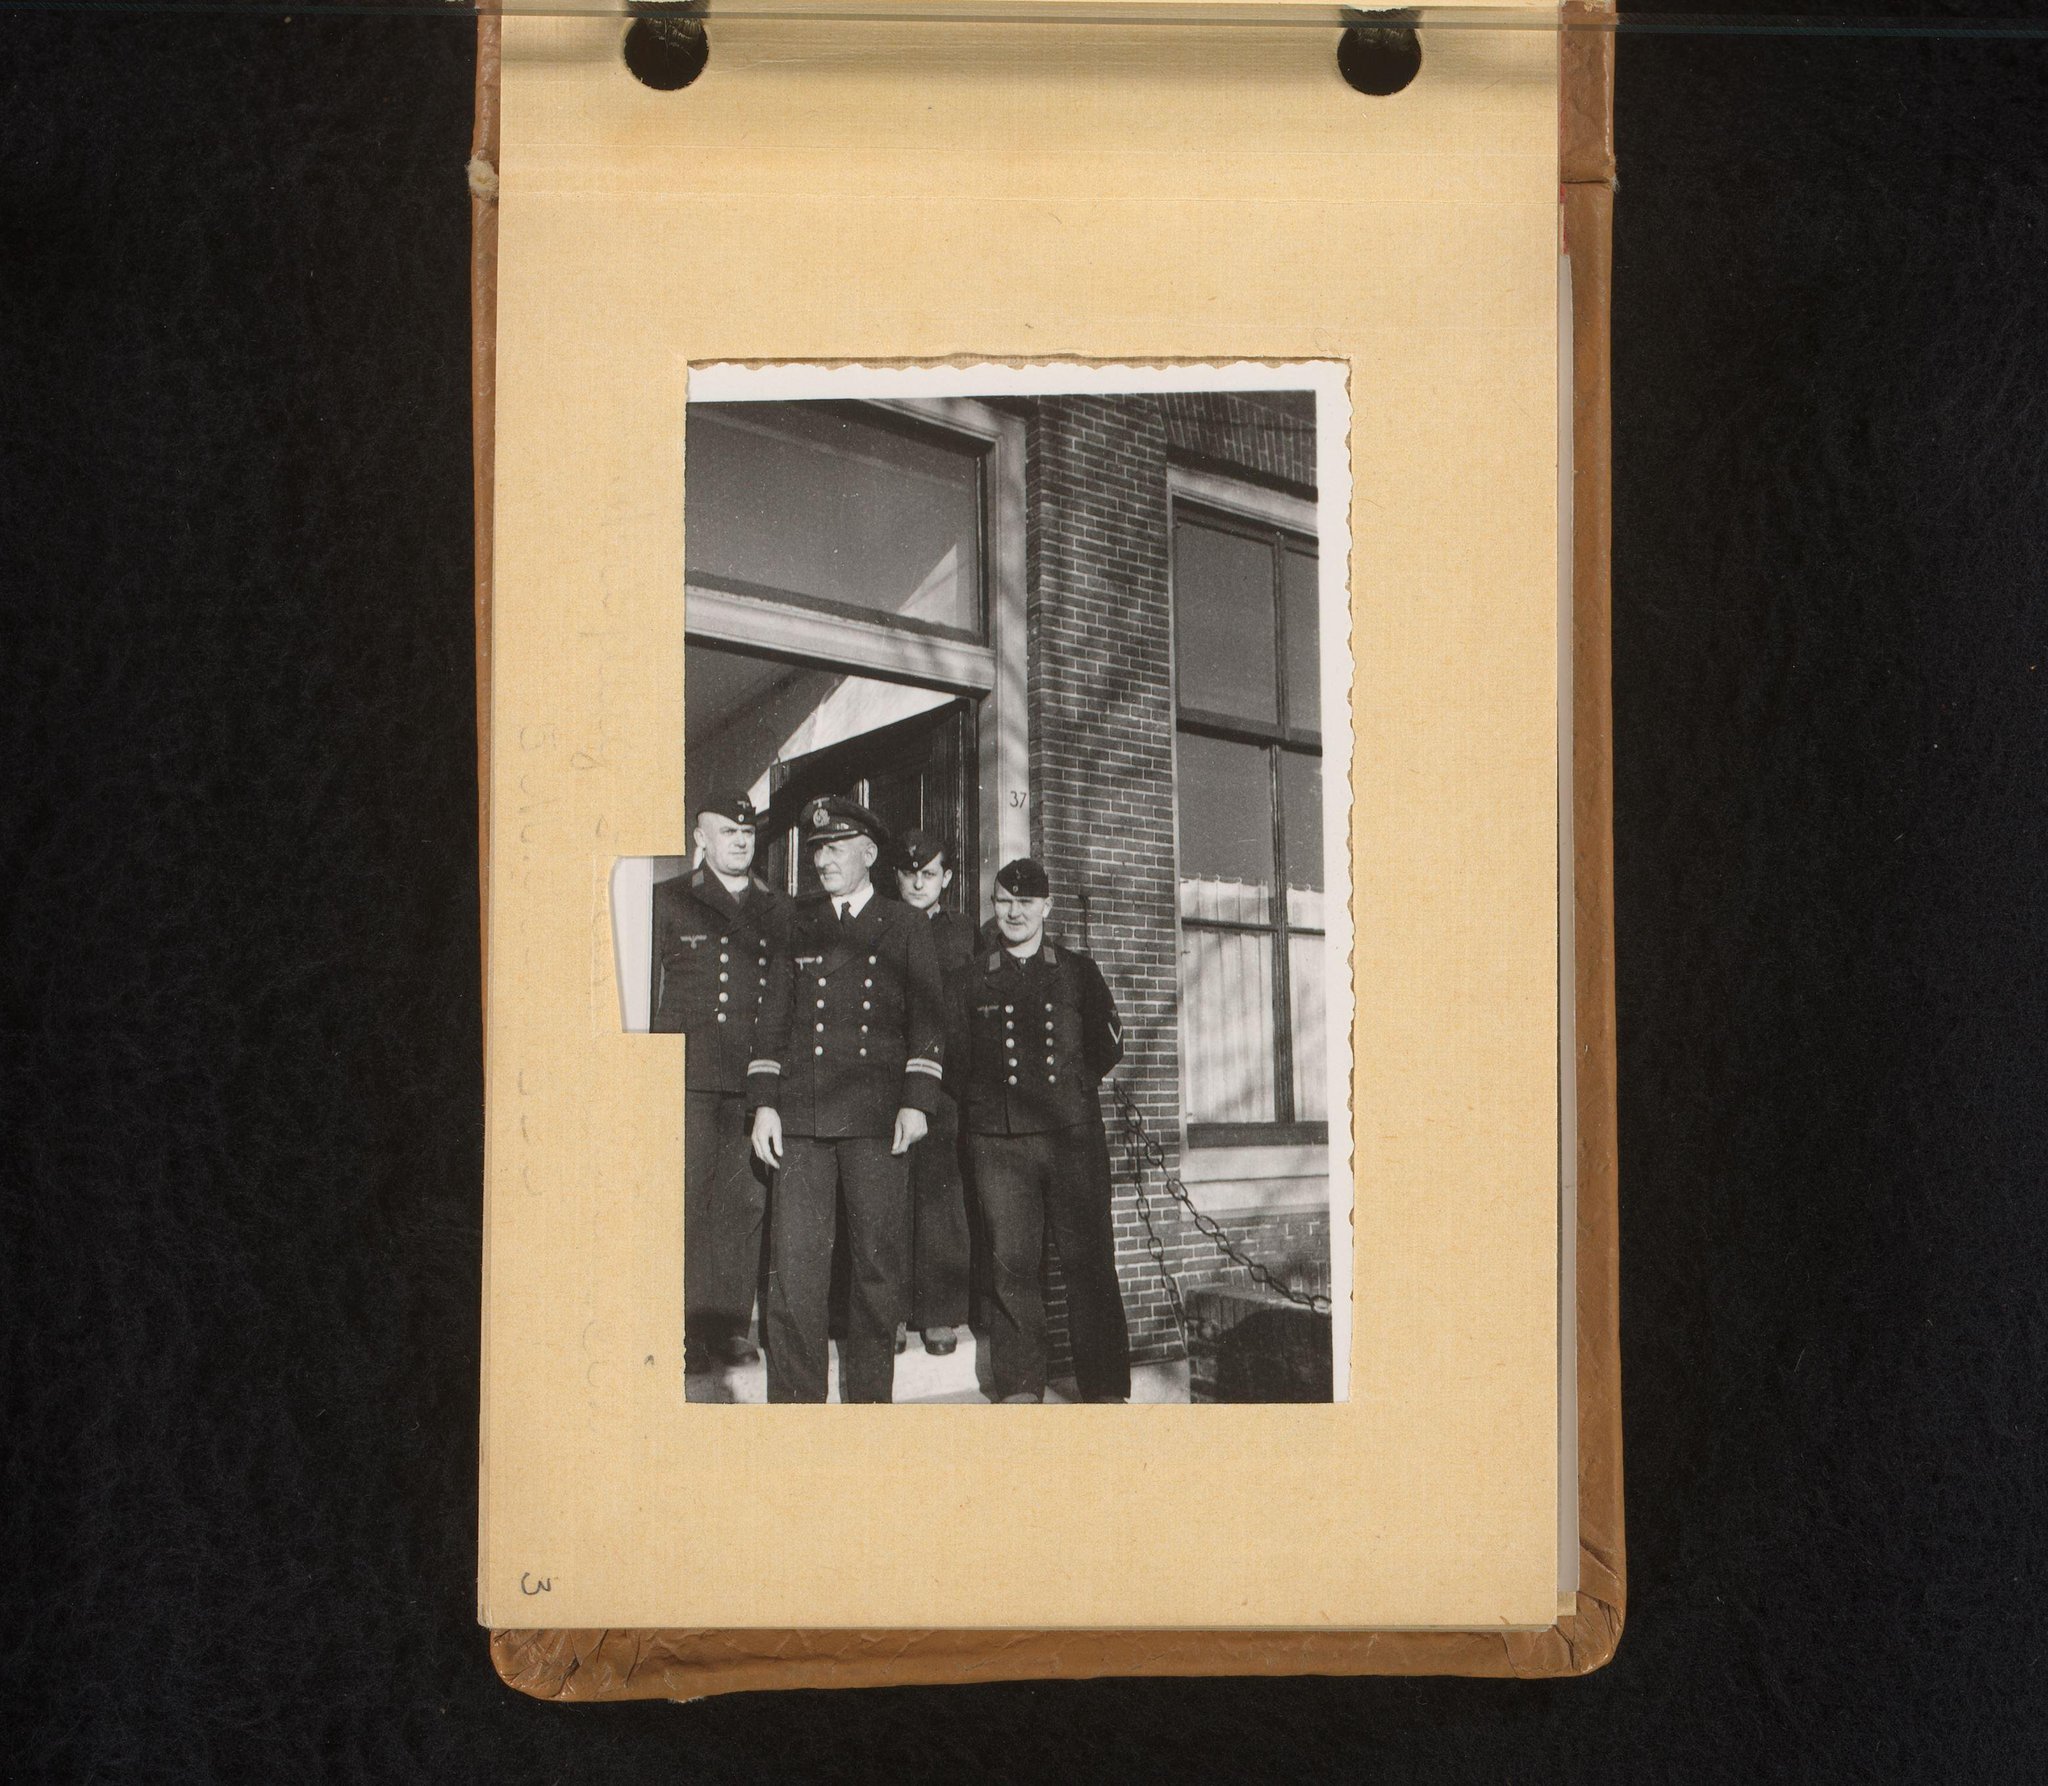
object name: album leaf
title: In de deur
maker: Anonymous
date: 1940-1943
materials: paper, photographic support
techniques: gelatin silver print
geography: netherlands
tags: the company, the unit, the troop ~ military service, shelter ~ military service, occupation ~ war, netherlands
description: Albumblad met een foto van vier militairen staande in de deuropening van het onderkomen van de Kriegsmarine in Nederland: Dienststelle 23 443. Onderdeel van een klein album van de Kriegsmarine in Nederland.